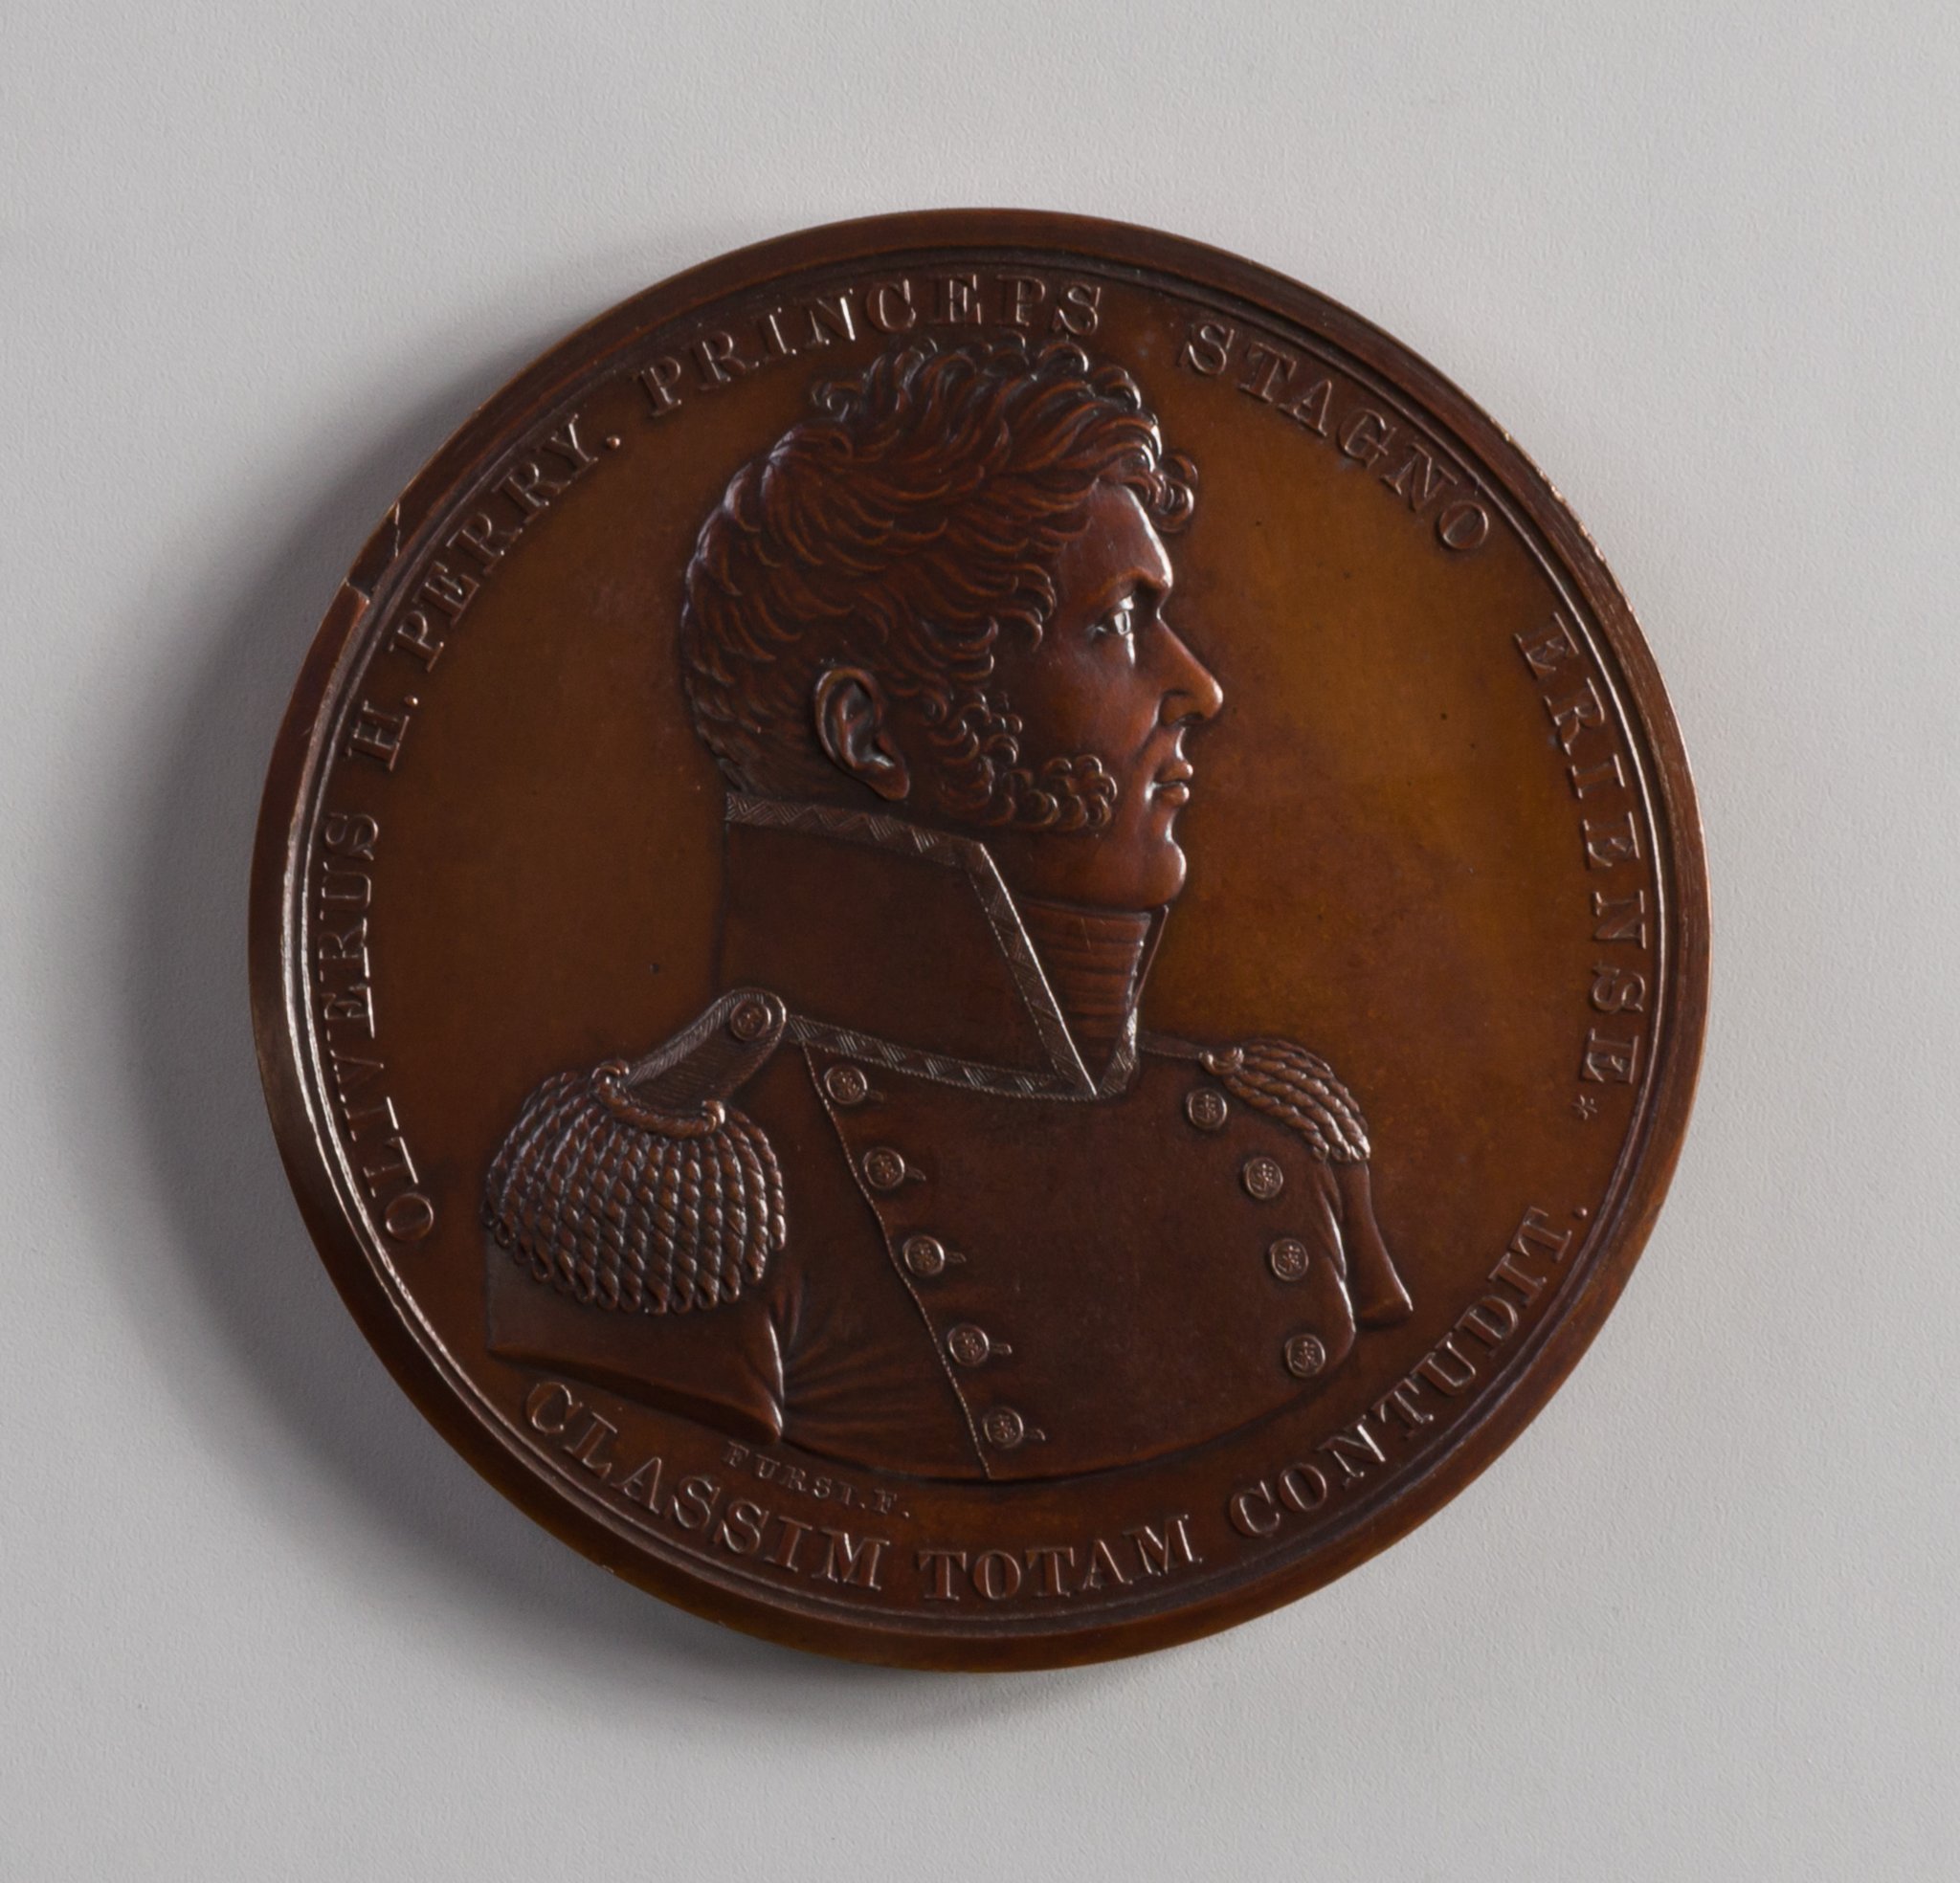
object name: medal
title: Medal of Captain O. H. Perry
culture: american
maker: moritz fürst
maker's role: maker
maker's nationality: hungarian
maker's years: 1782-1882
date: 1813-1815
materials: bronze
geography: united states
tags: men,profiles